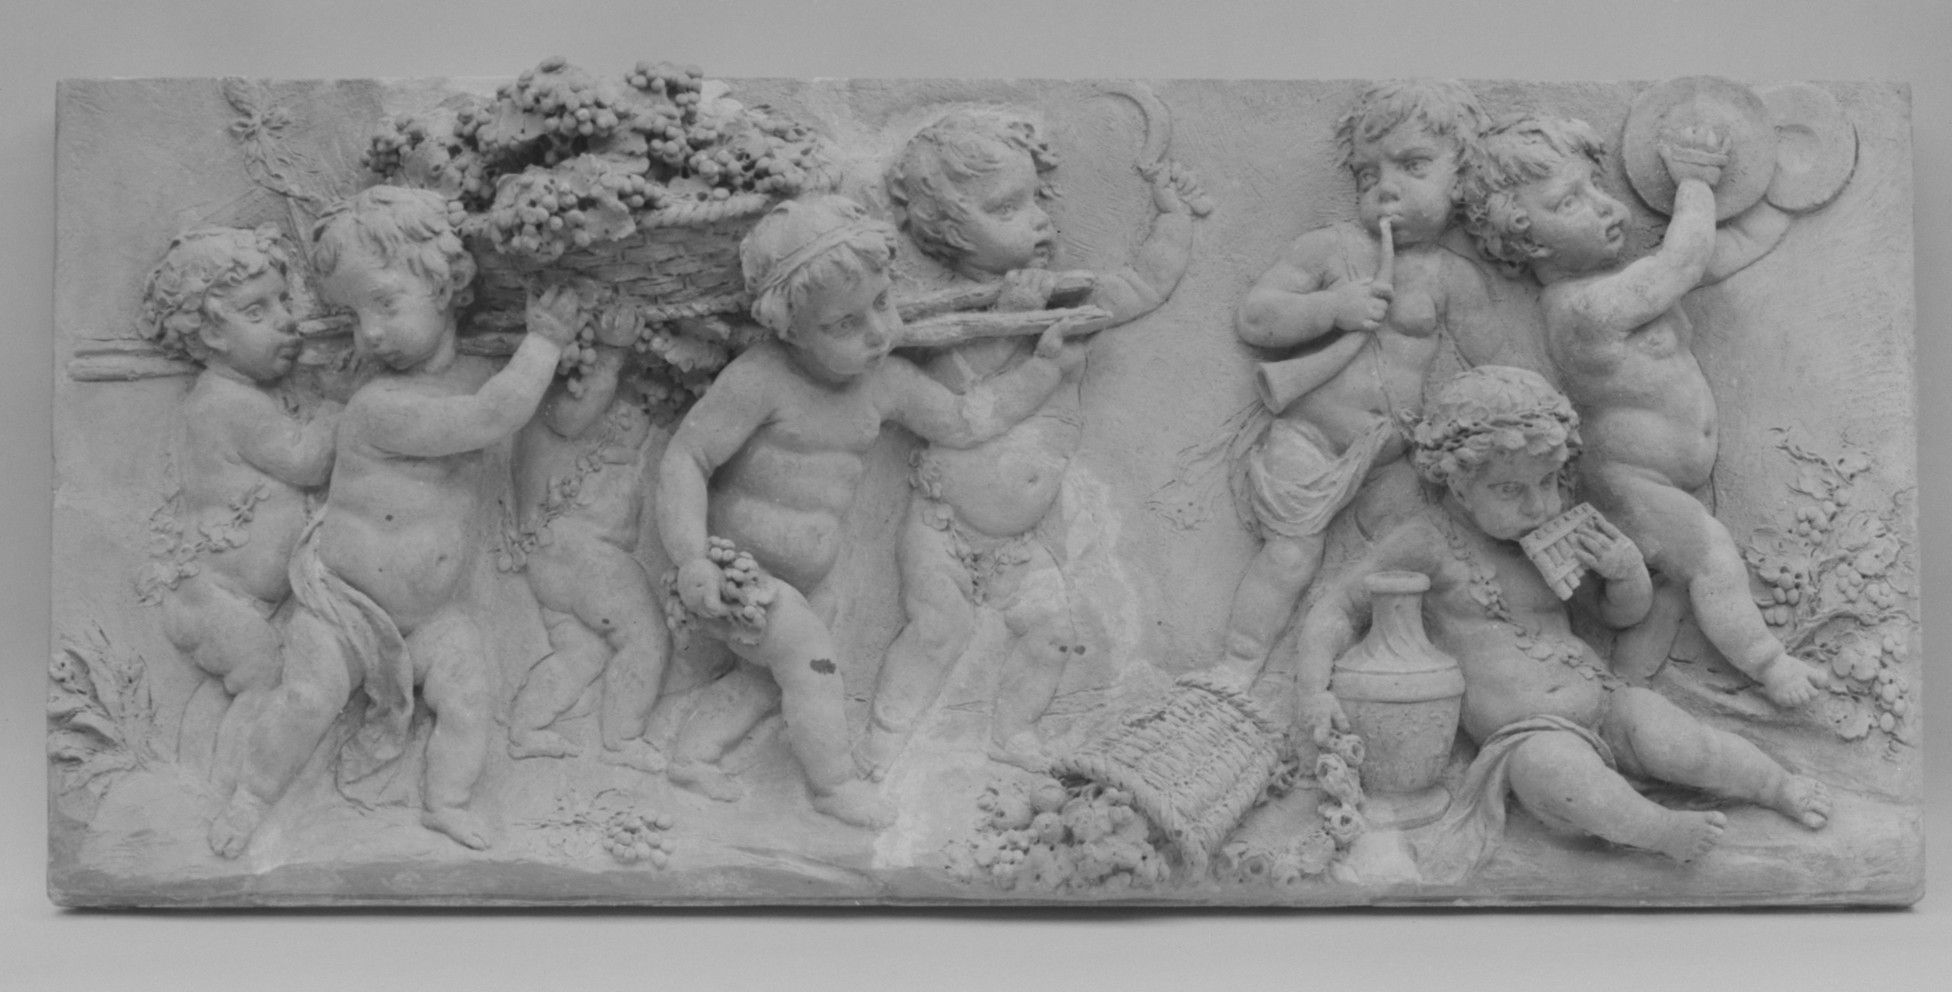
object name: plaque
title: Autumn (one of a pair)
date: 1701-1800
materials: terracotta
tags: musical instruments,grapes,putti